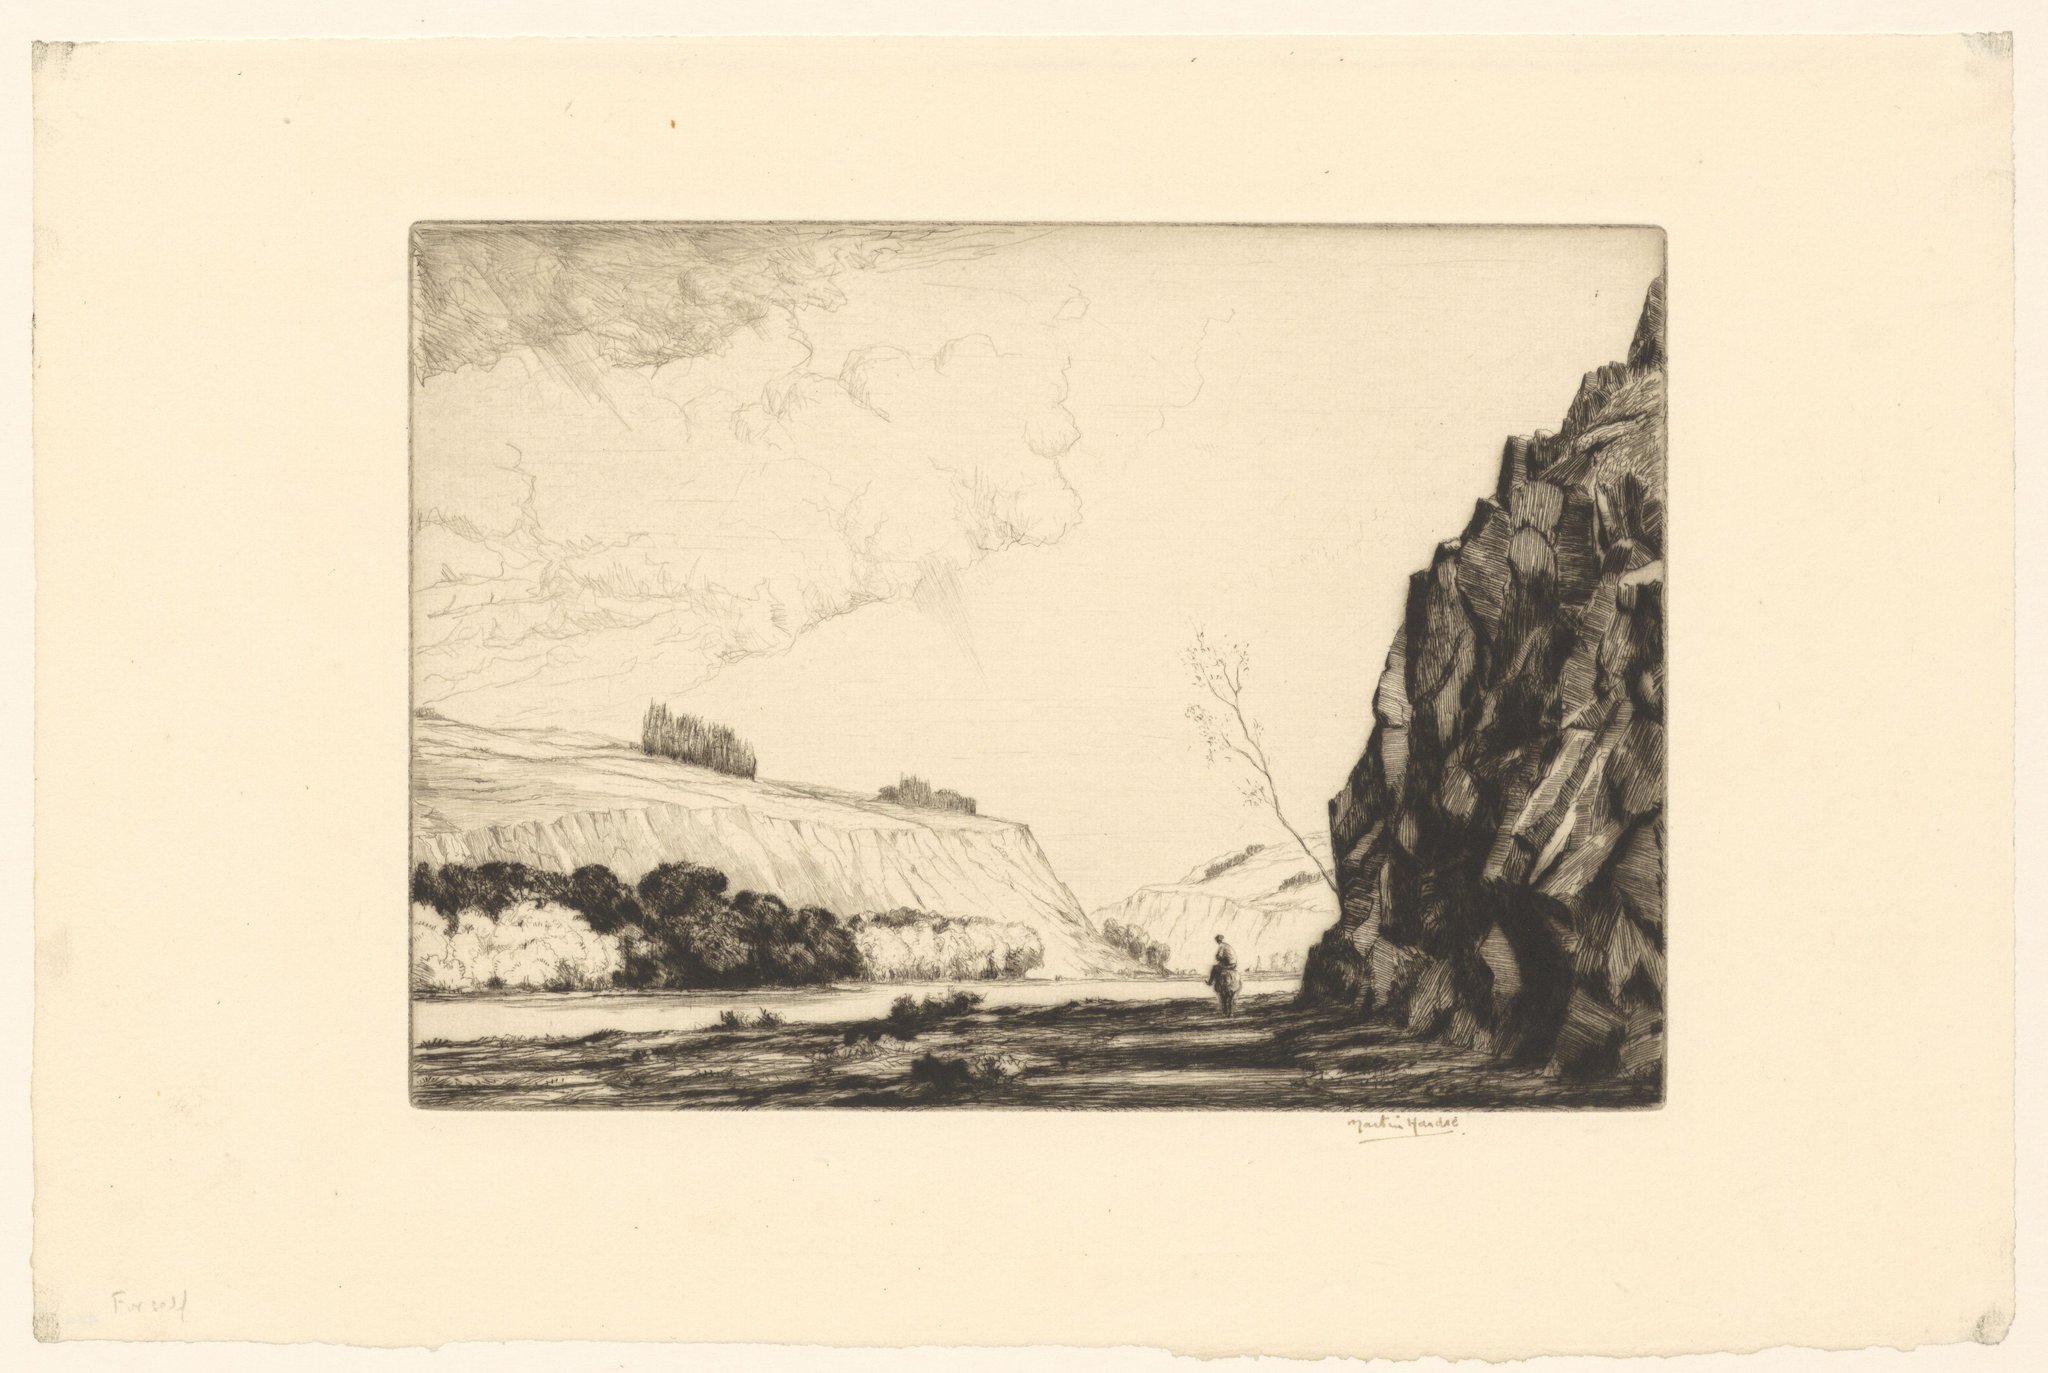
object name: print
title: In the Ardennes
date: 1929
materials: paper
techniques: drypoint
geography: houffalize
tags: riding a horse, ass, or mule; rider, horseman, road, path, rocks (+ landscape with figures, staffage)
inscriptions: collector's mark: Lugt 2760, annotation: ‘Martin Hardie’, collector's mark: Lugt 2228